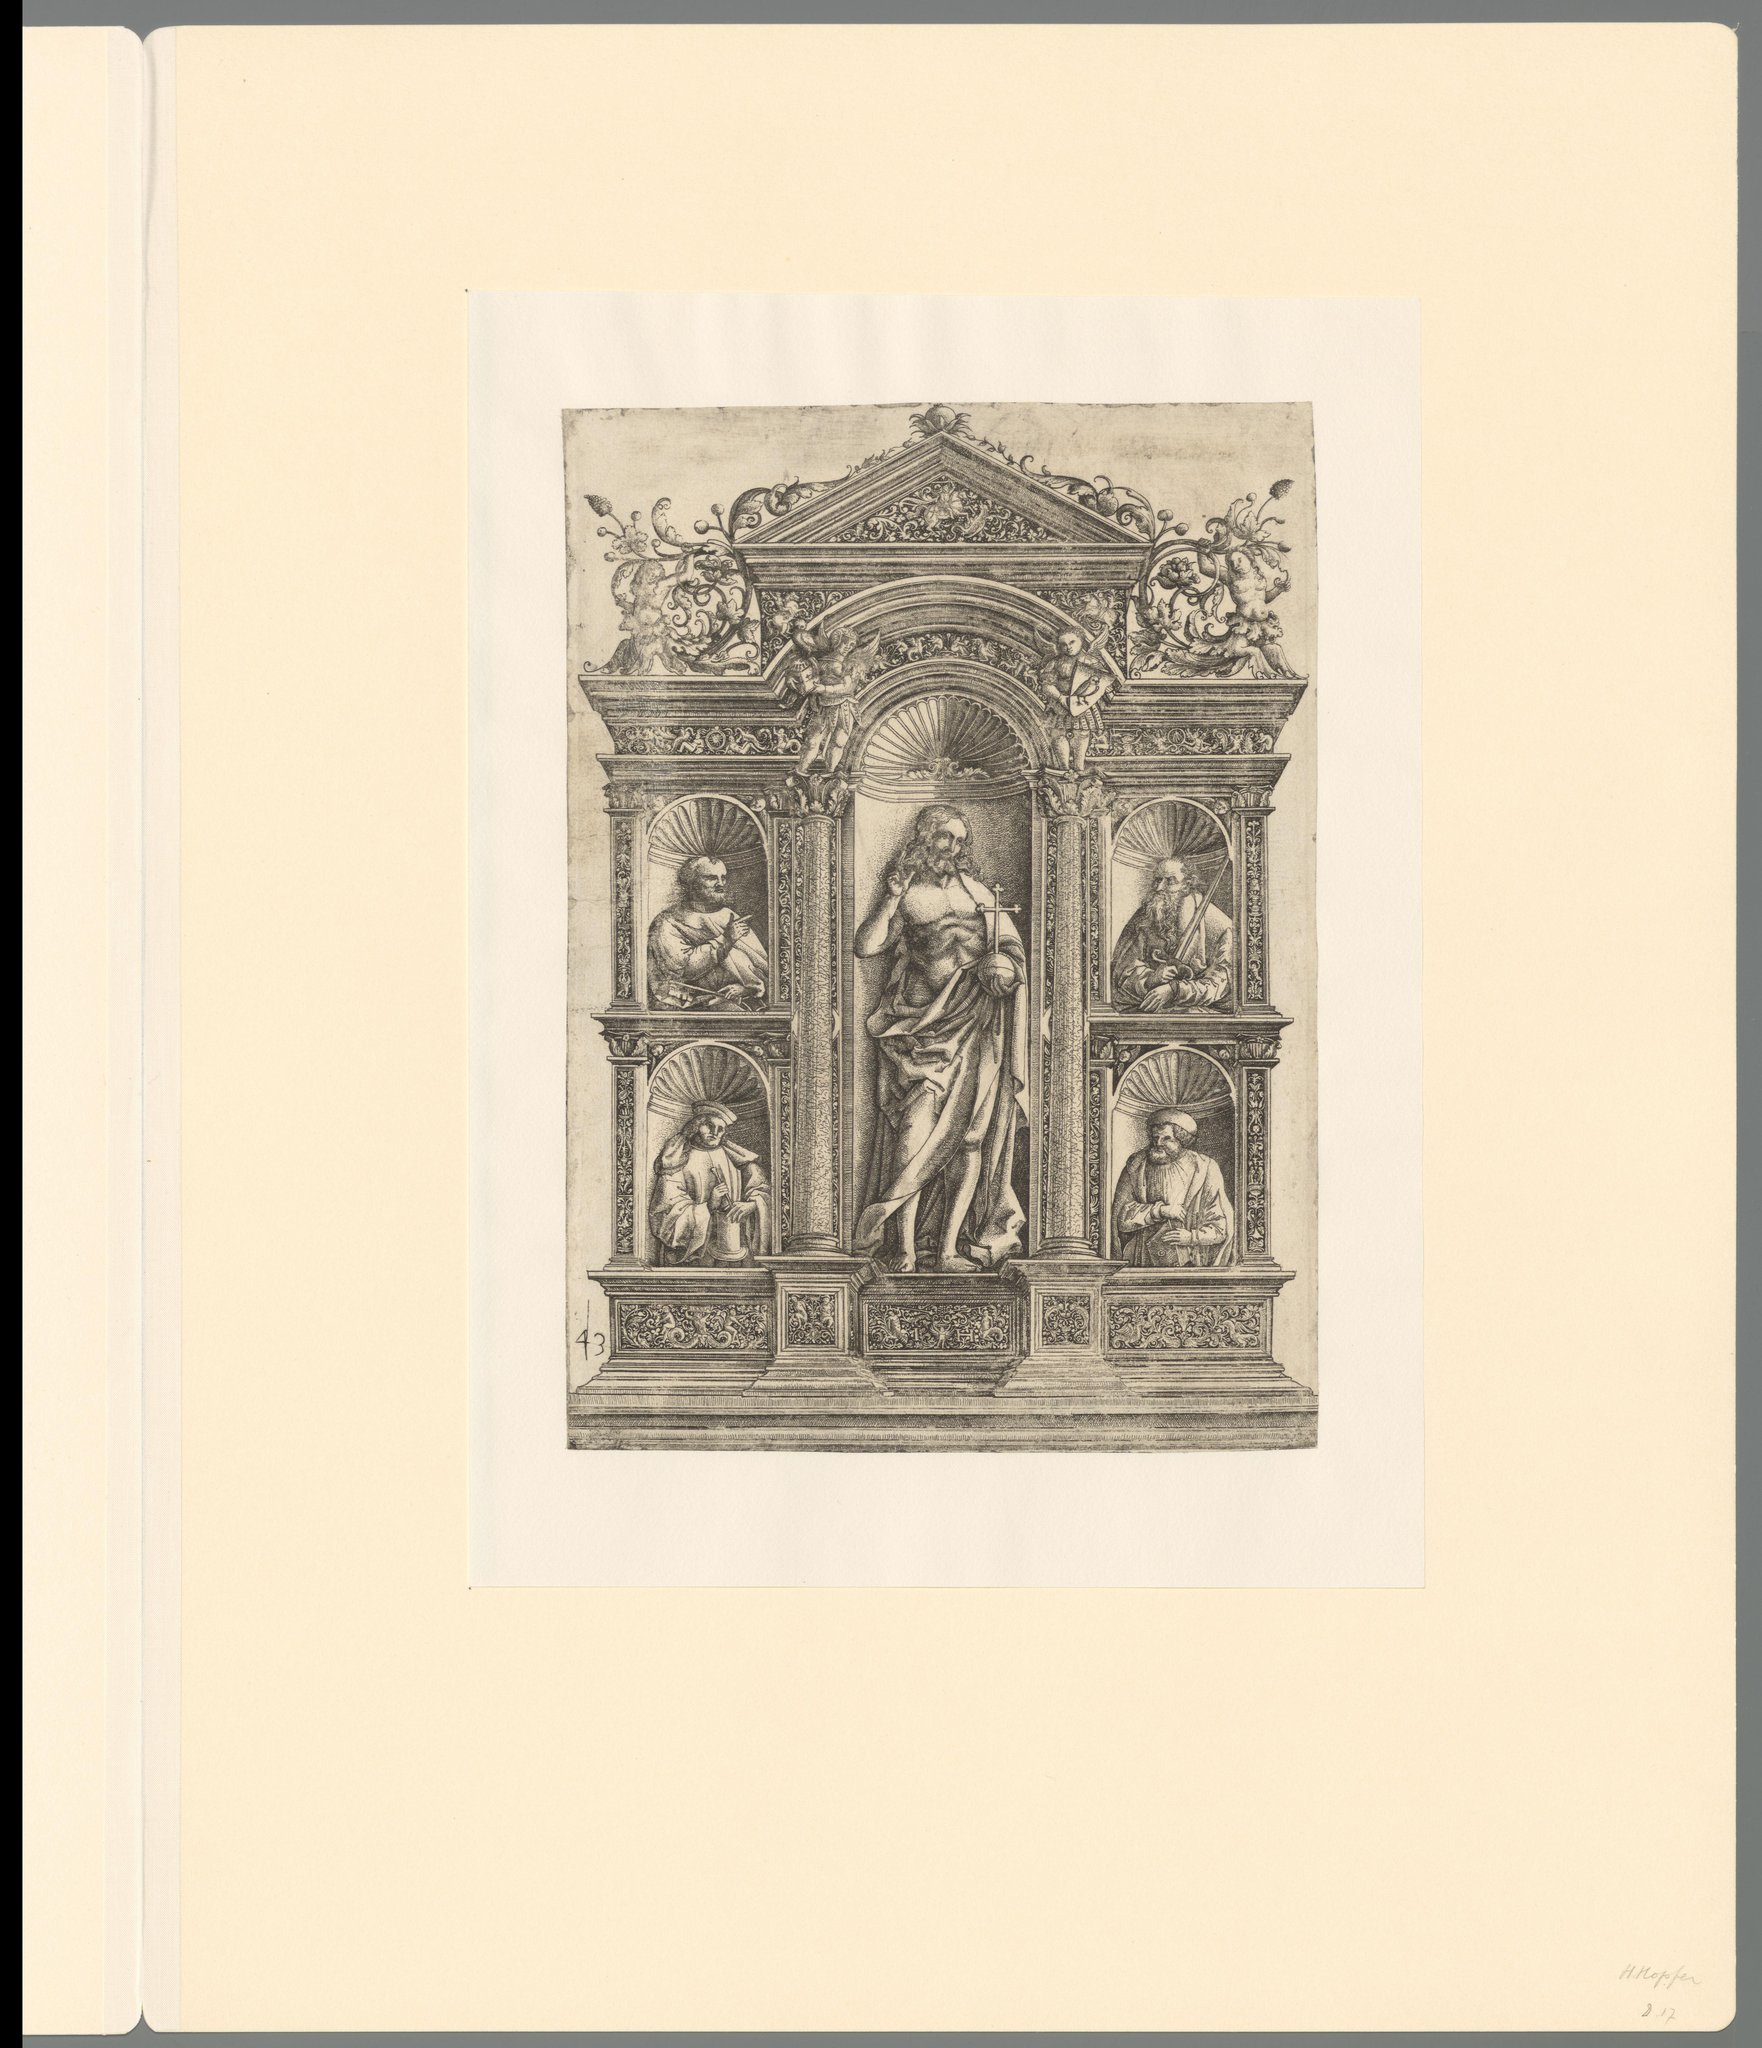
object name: print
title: Christus als Salvator Mundi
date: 1525-1550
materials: paper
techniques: etching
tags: 'salvator mundi', making a blessing gesture; an orb in his hand or at his feet, the twin-brothers cosmas and damian(us), martyrs and physicians; possible attributes: box of ointment, cap, gown, lancet, pestle and mortar, urinal, altar with altar-piece, the apostle peter, first bishop of rome; possible attributes: book, cock, (upturned) cross, (triple) crozier, fish, key, scroll, ship, tiara, the apostle paul of tarsus; possible attributes: book, scroll, sword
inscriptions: collector's mark: Lugt 2760, collector's mark: Lugt 2228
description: David Funck (1642-1709) kocht 230 ijzeren platen van de prentenmakers uit de familie Hopfer aan, nummerde deze (nu bekend als het Funck nummer) en herdrukte de verder onaangetaste platen onder de titel Operae Hopferianae in 1684 in Neurenberg. (Metzger, 2009)